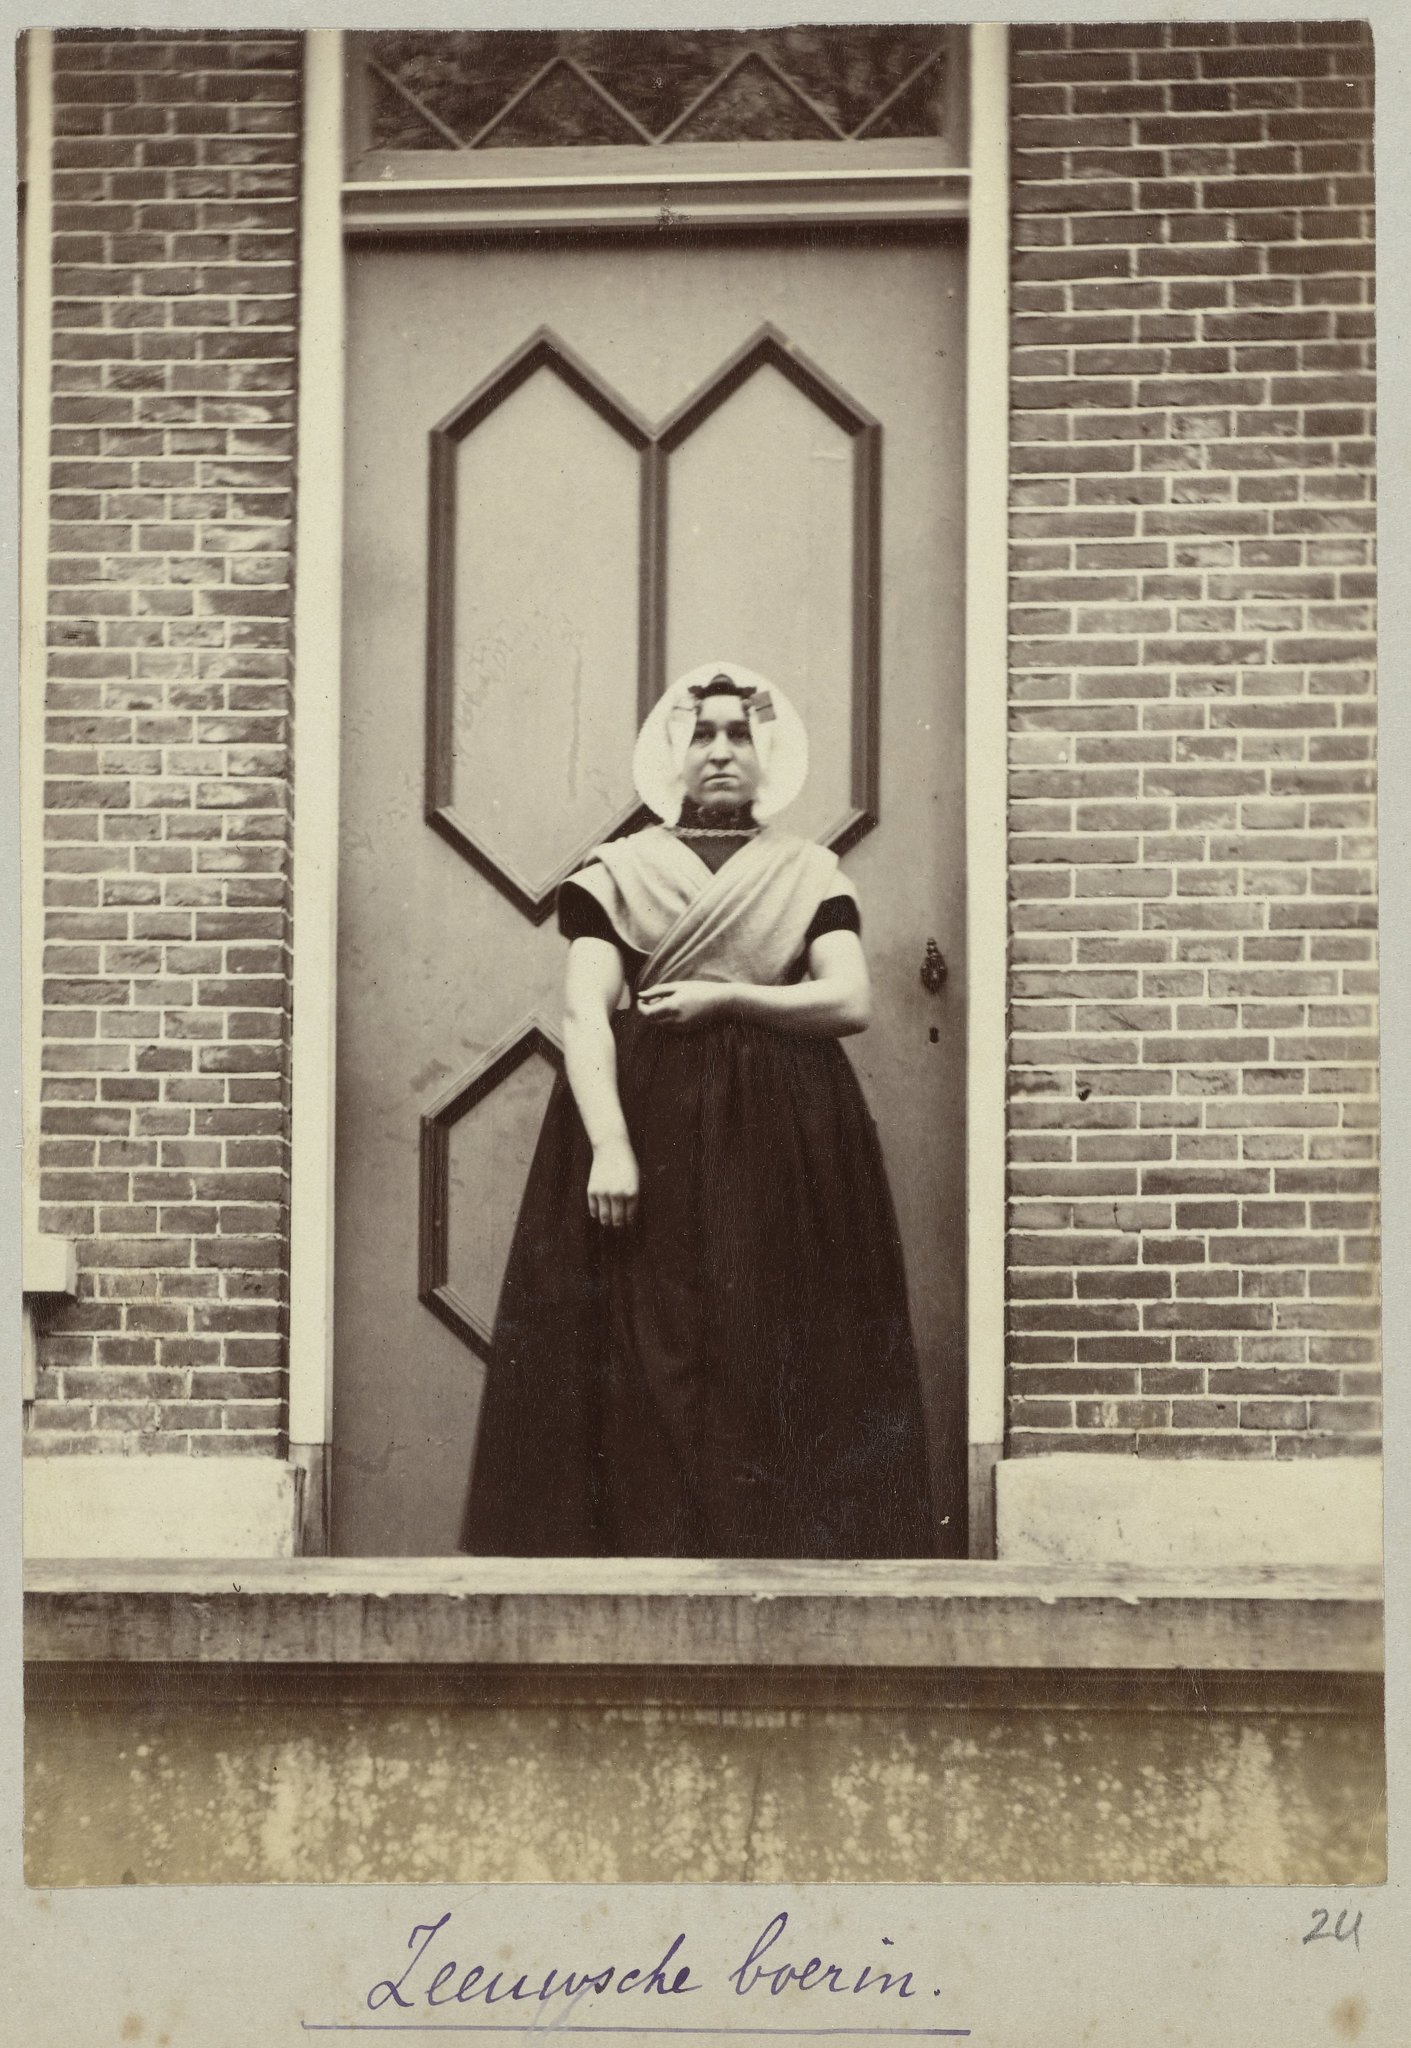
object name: photograph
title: Portret van een vrouw in Zuid-Bevelandse klederdracht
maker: henry pauw van wieldrecht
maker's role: fotograaf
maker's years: 1863-1912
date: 1888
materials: paper, photographic support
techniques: albumen print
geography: netherlands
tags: zuid-beveland